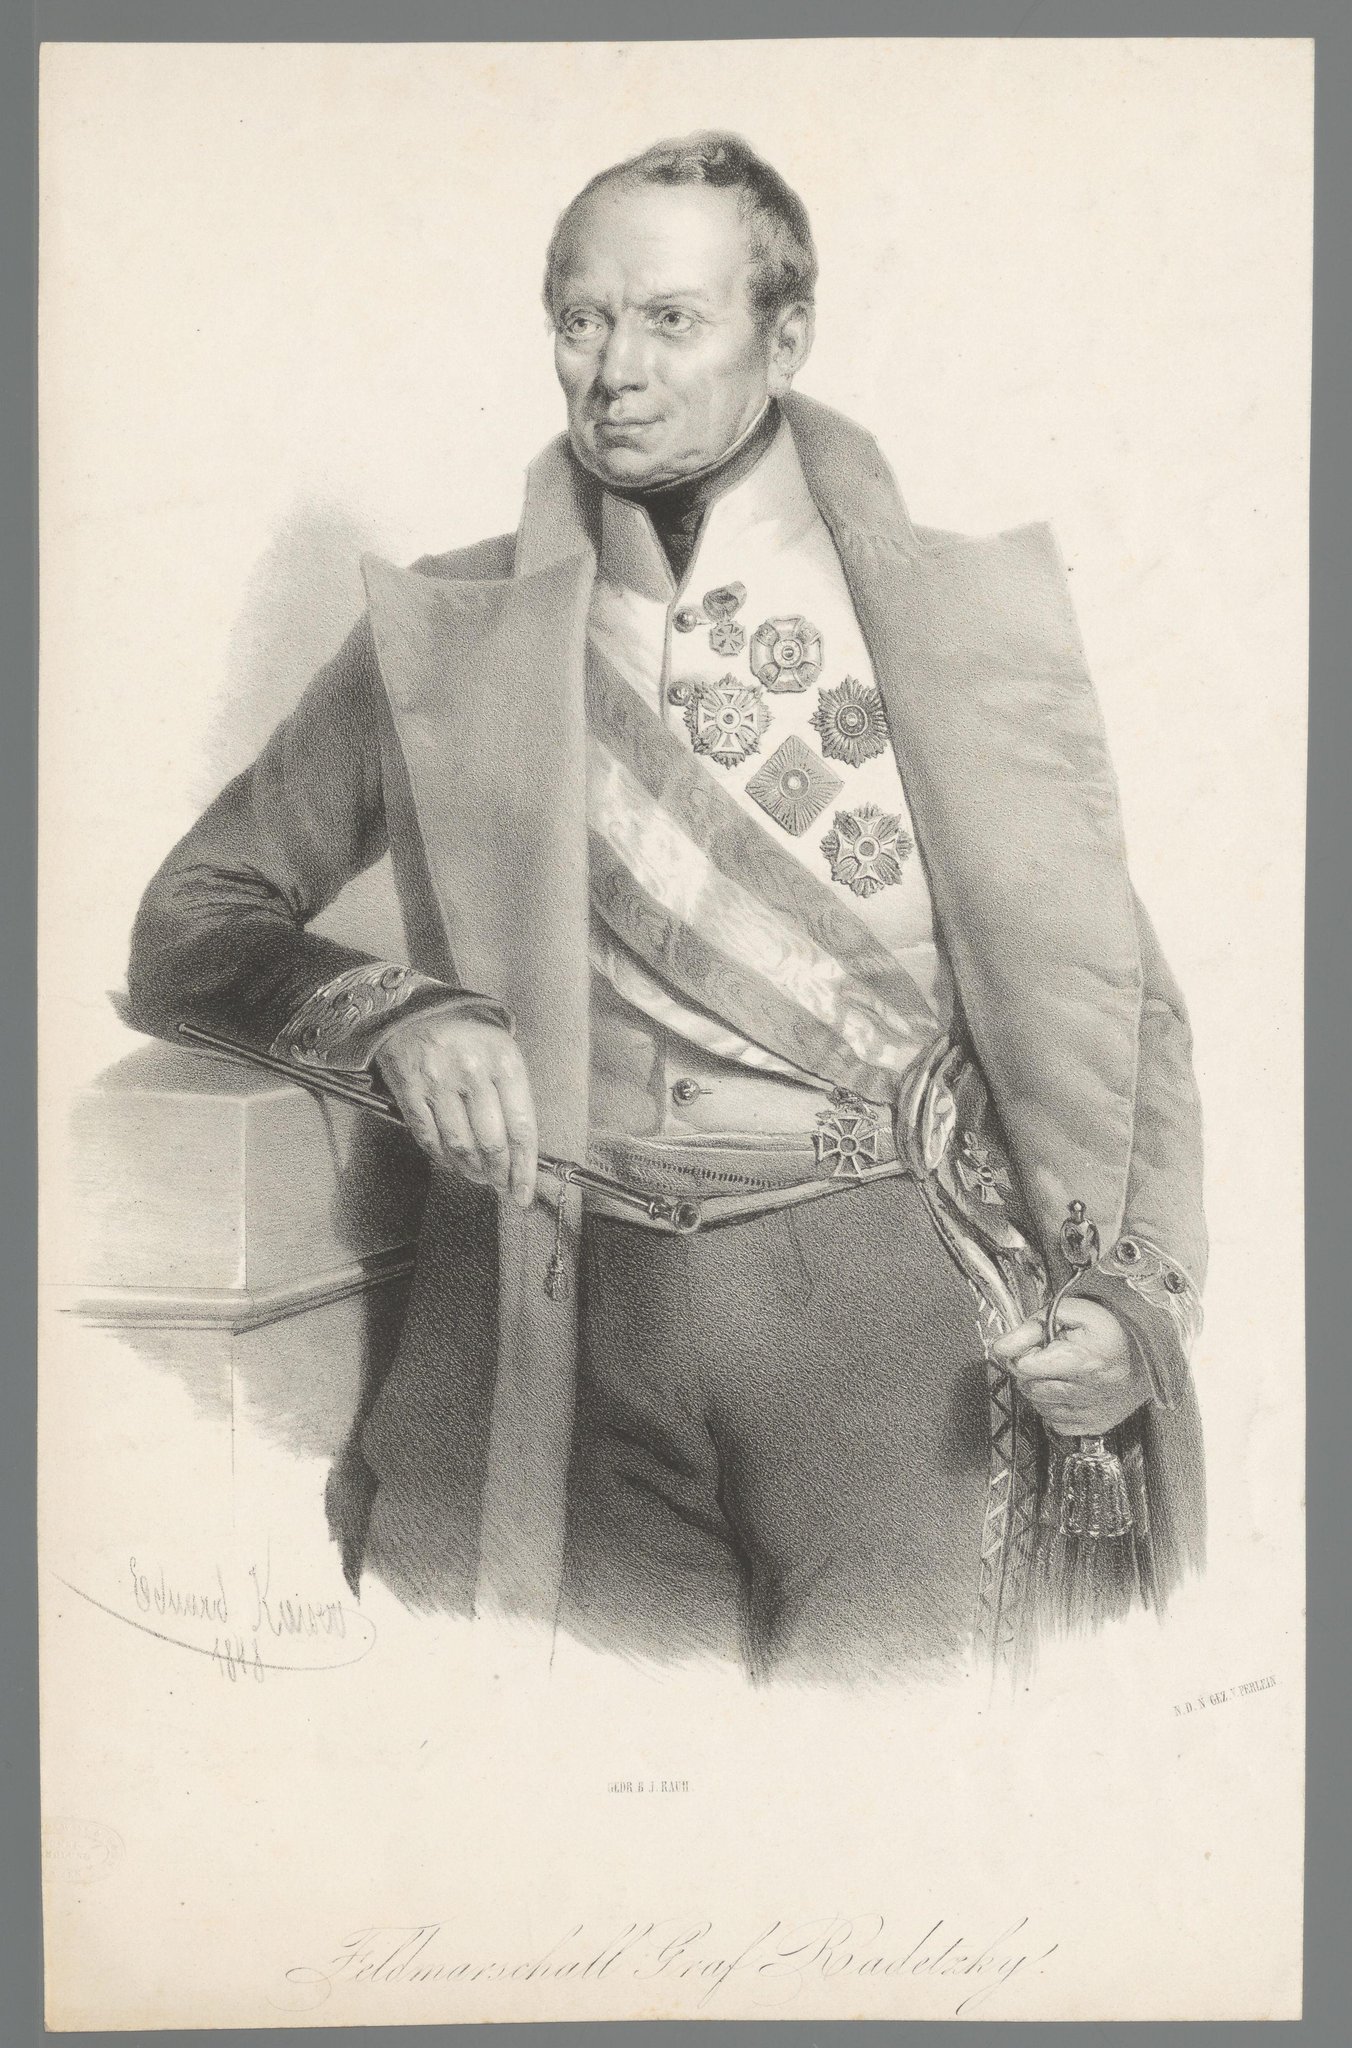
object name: print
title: Portret van Josef Wenzel Radetzky von Radetz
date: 1848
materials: paper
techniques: lithograph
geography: vienna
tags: adult man, historical persons, (military) uniforms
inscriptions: check stamp: ‘A. Paterno s Wtwe. & Sohn Kunsthandlung in Wien’, collector's mark: Lugt 2228